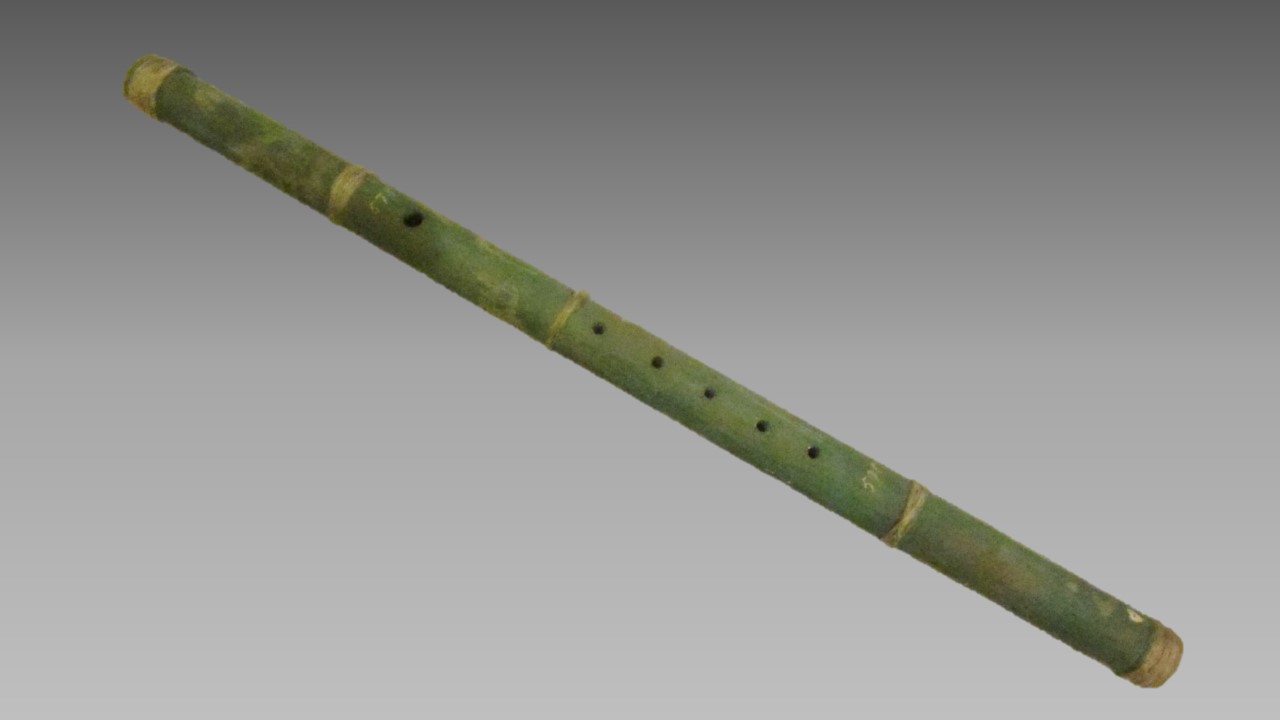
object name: flute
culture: native american, apache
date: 1801-1900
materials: wood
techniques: polychrome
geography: united states